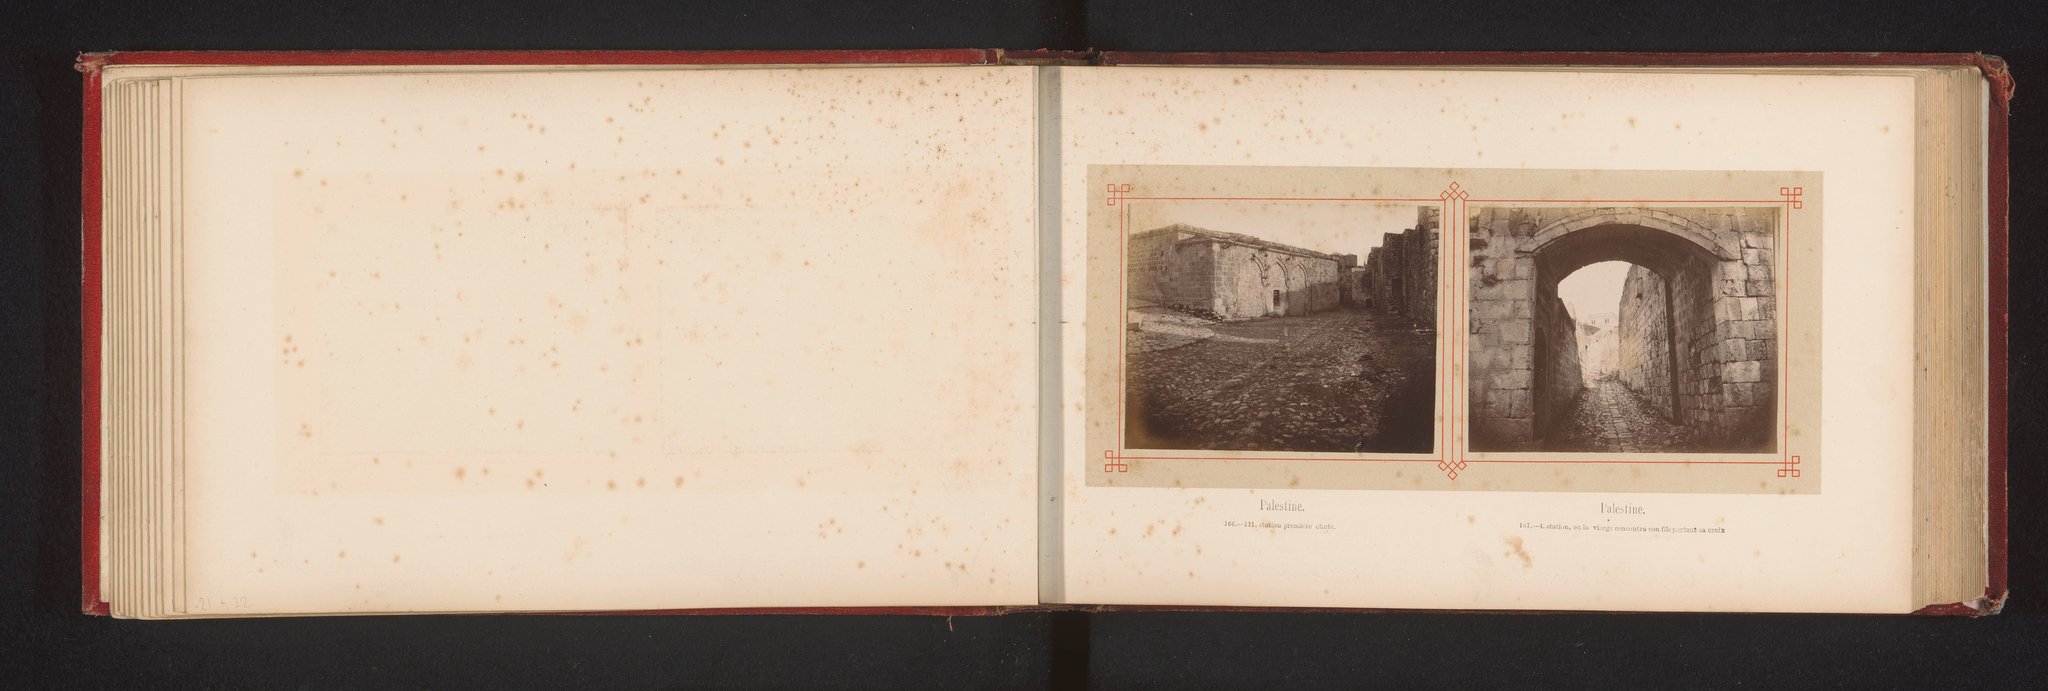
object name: page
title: Gezicht op een weg met daaraan gebouwen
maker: félix bonfils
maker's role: fotograaf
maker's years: 1831-1885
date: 1873-1878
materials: photographic support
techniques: albumen print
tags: road, path, civic architecture; edifices; dwellings